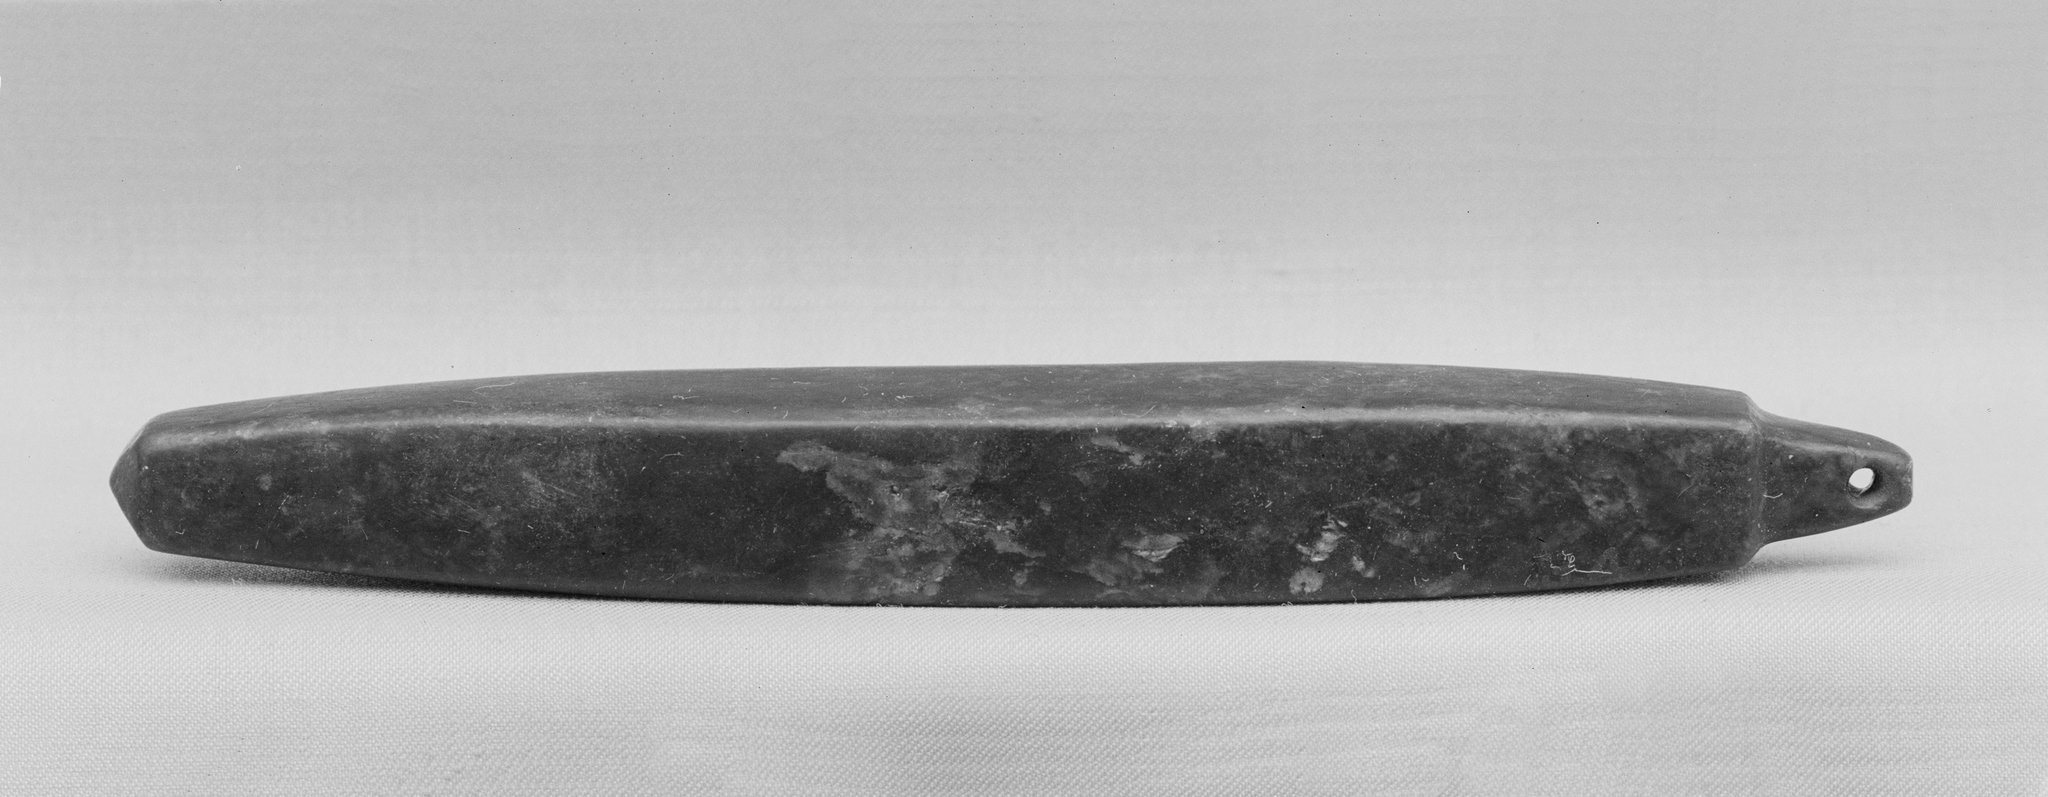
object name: pendant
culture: chinese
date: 3200-2000 BCE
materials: jade